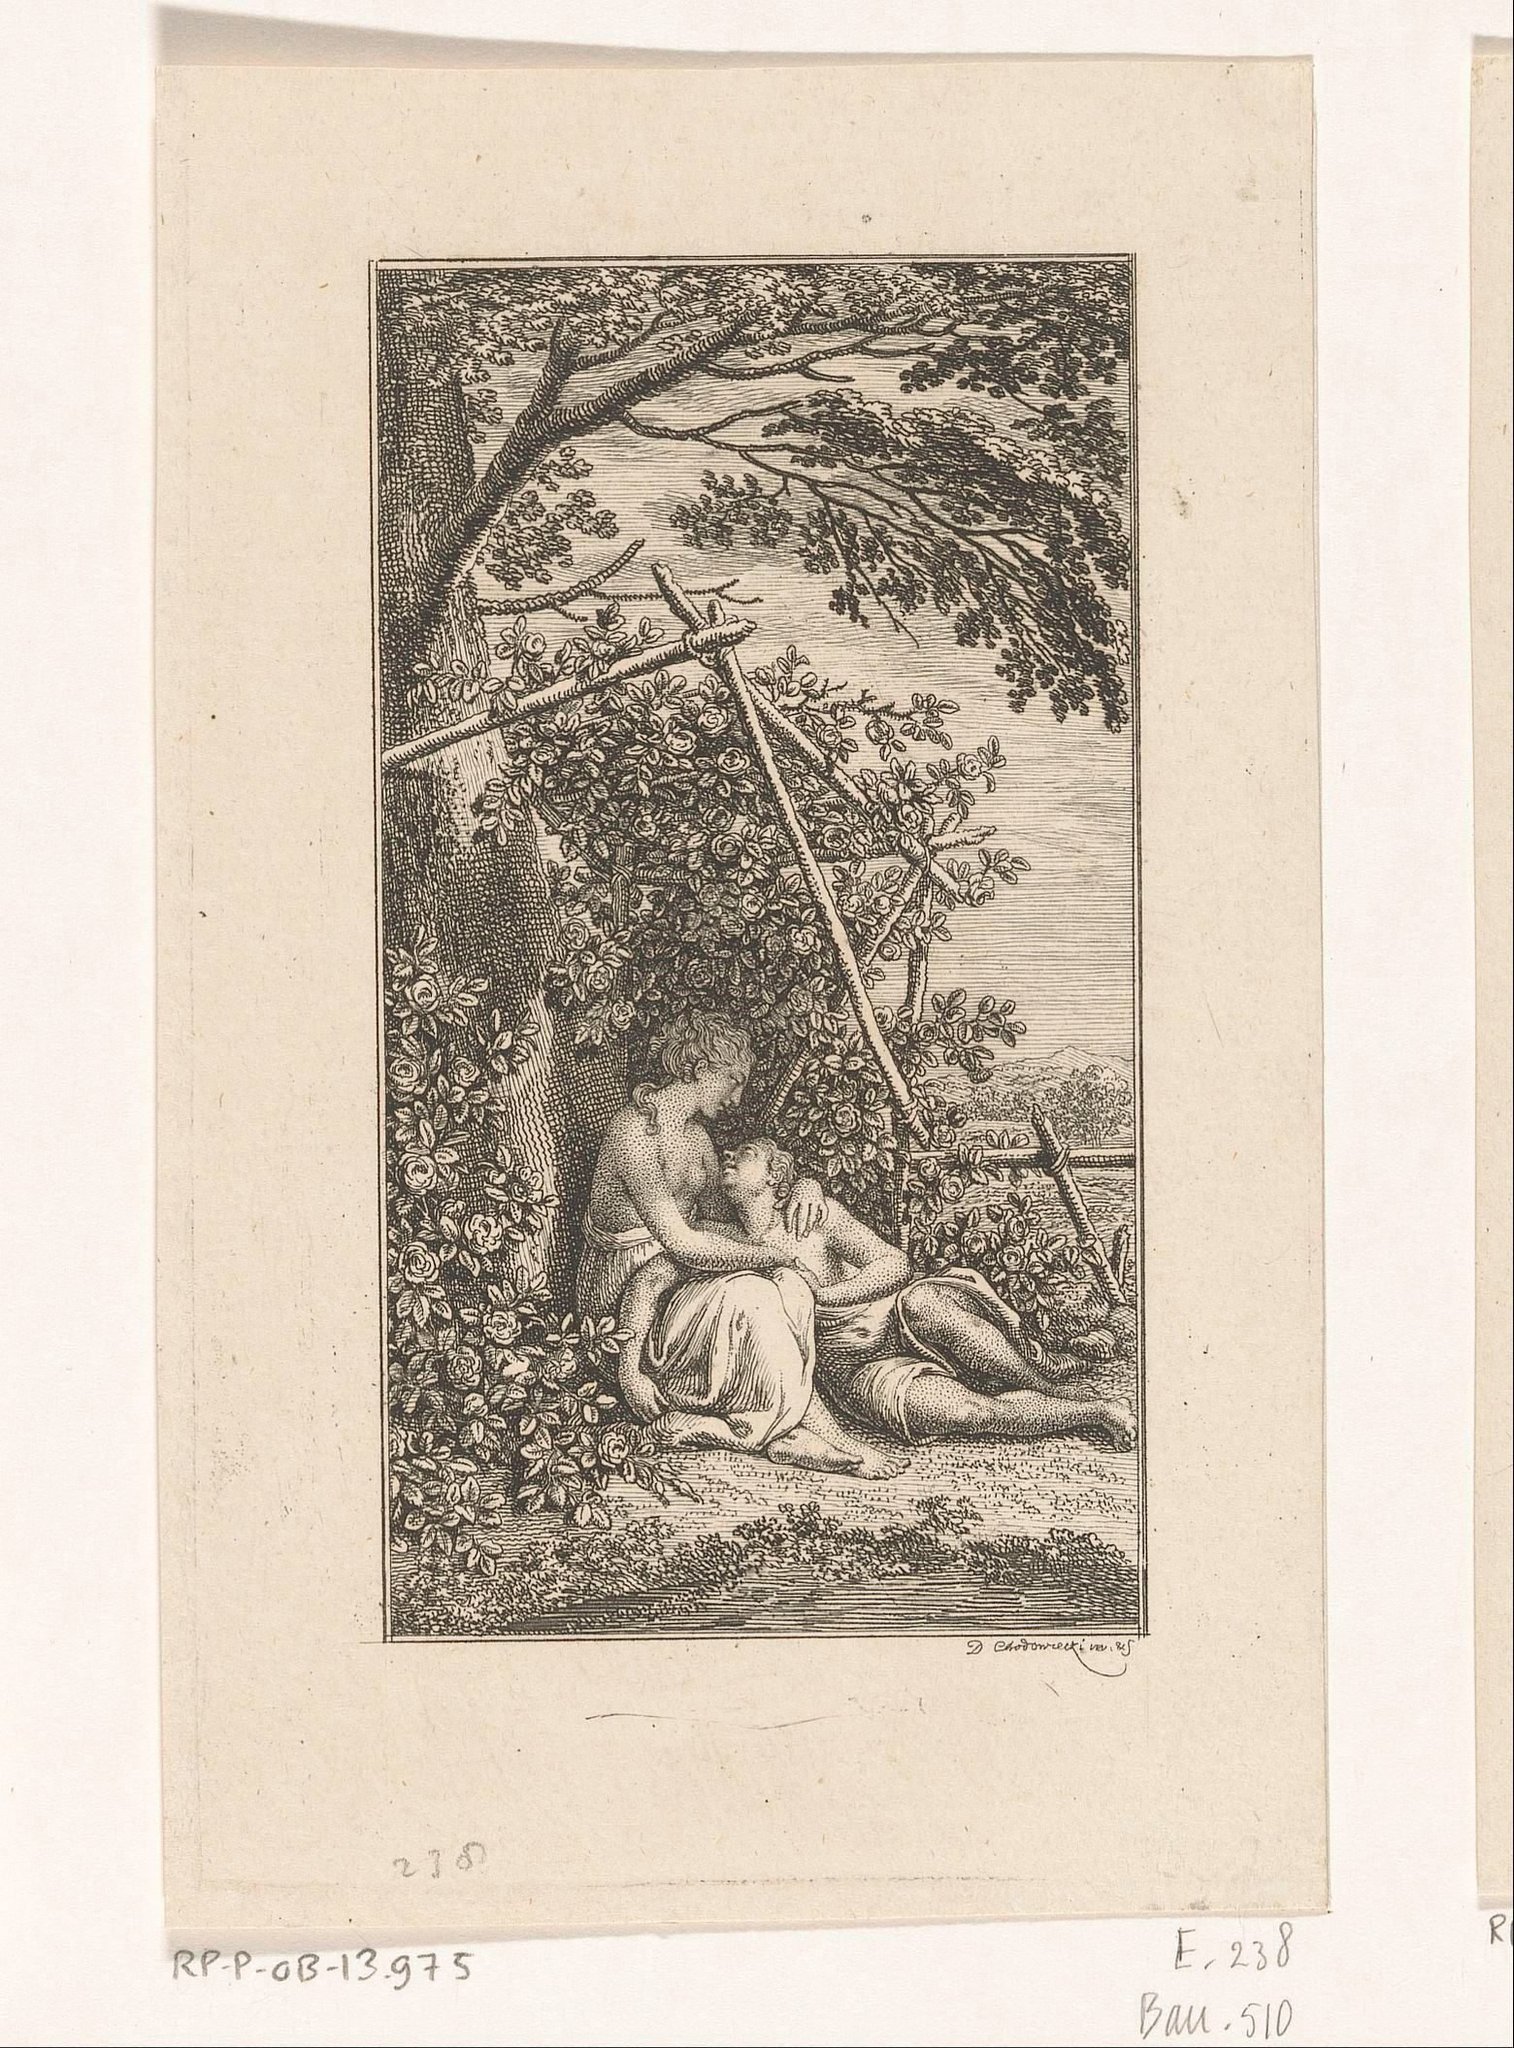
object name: print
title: Liefdespaar in een arcadisch landschap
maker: daniel nikolaus chodowiecki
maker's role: draughtsman, print maker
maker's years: 1726-1801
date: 1778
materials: paper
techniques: etching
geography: berlin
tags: pastorals, arcadian scenes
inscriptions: collector's mark: Lugt 2228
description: Vijfde uit een serie van acht scènes die de gedichten van Gottfried August Bürger illustreren. De scènes werden op twee platen geëtst. Een latere staat van deze serie is gebruikt in: Bürger, Gottfried August. Göttingen: Johann Christian Dieterich, 1778.